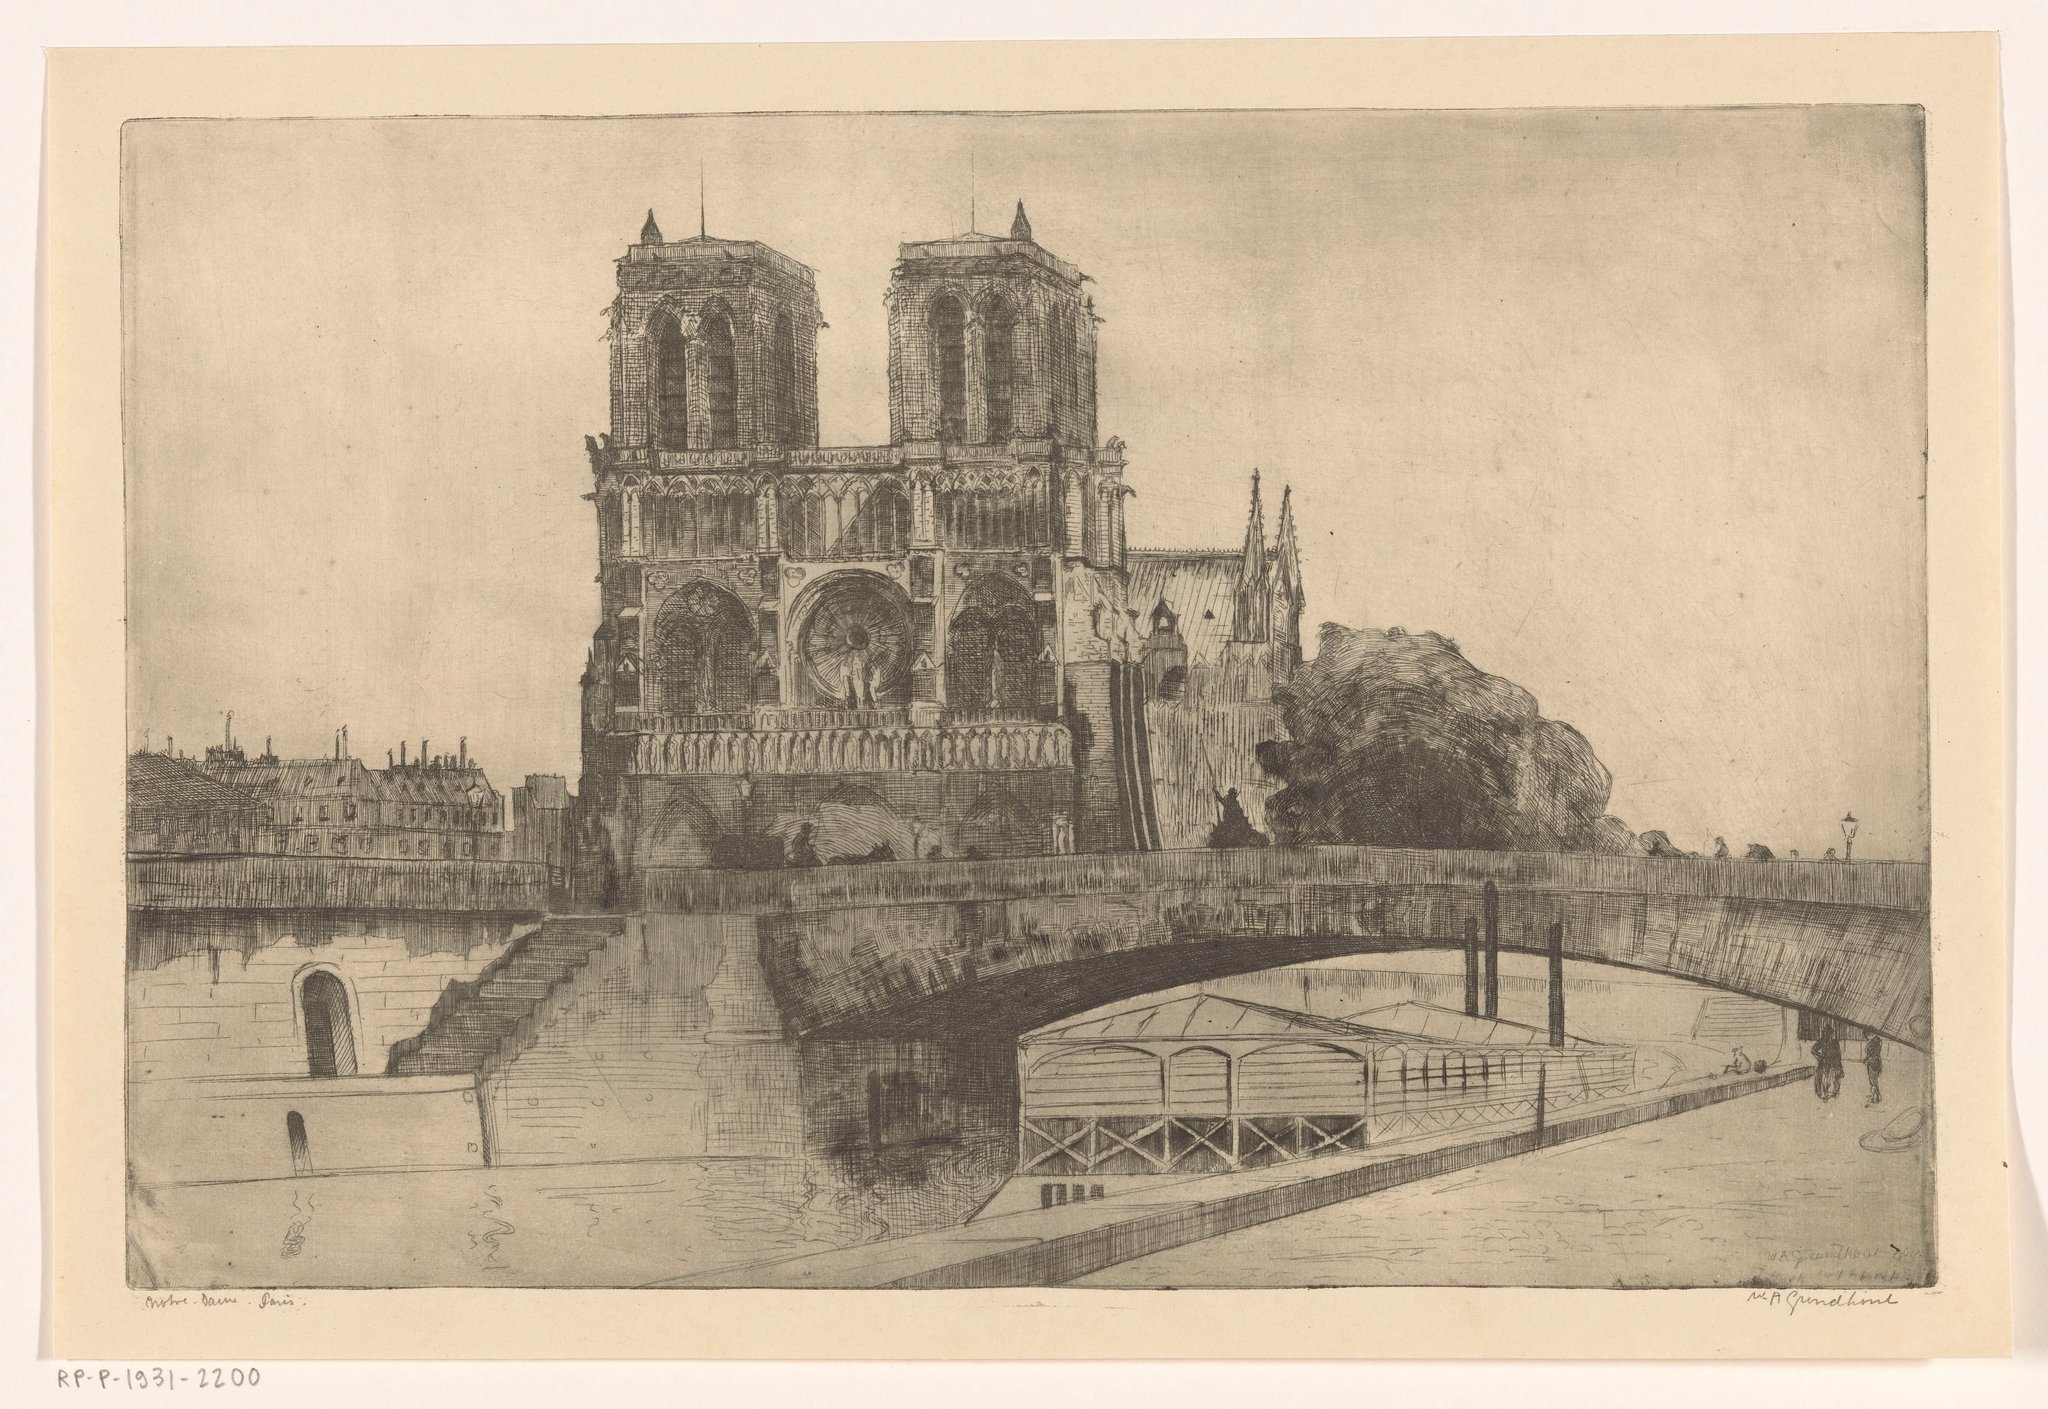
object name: print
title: Notre-Dame, Paris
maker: willem adrianus grondhout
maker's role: draughtsman, painter, print maker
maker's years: 1878-1934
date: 1888-1931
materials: paper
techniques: etching, intaglio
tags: church (exterior), bridge in city across river, canal, etc., quay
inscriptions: collector's mark: Lugt 2228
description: De Notre-Dame in Parijs, gezien vanaf de Quai de Montebello. Op de voorgrond de Seine die onder de Pont au Double stroomt.